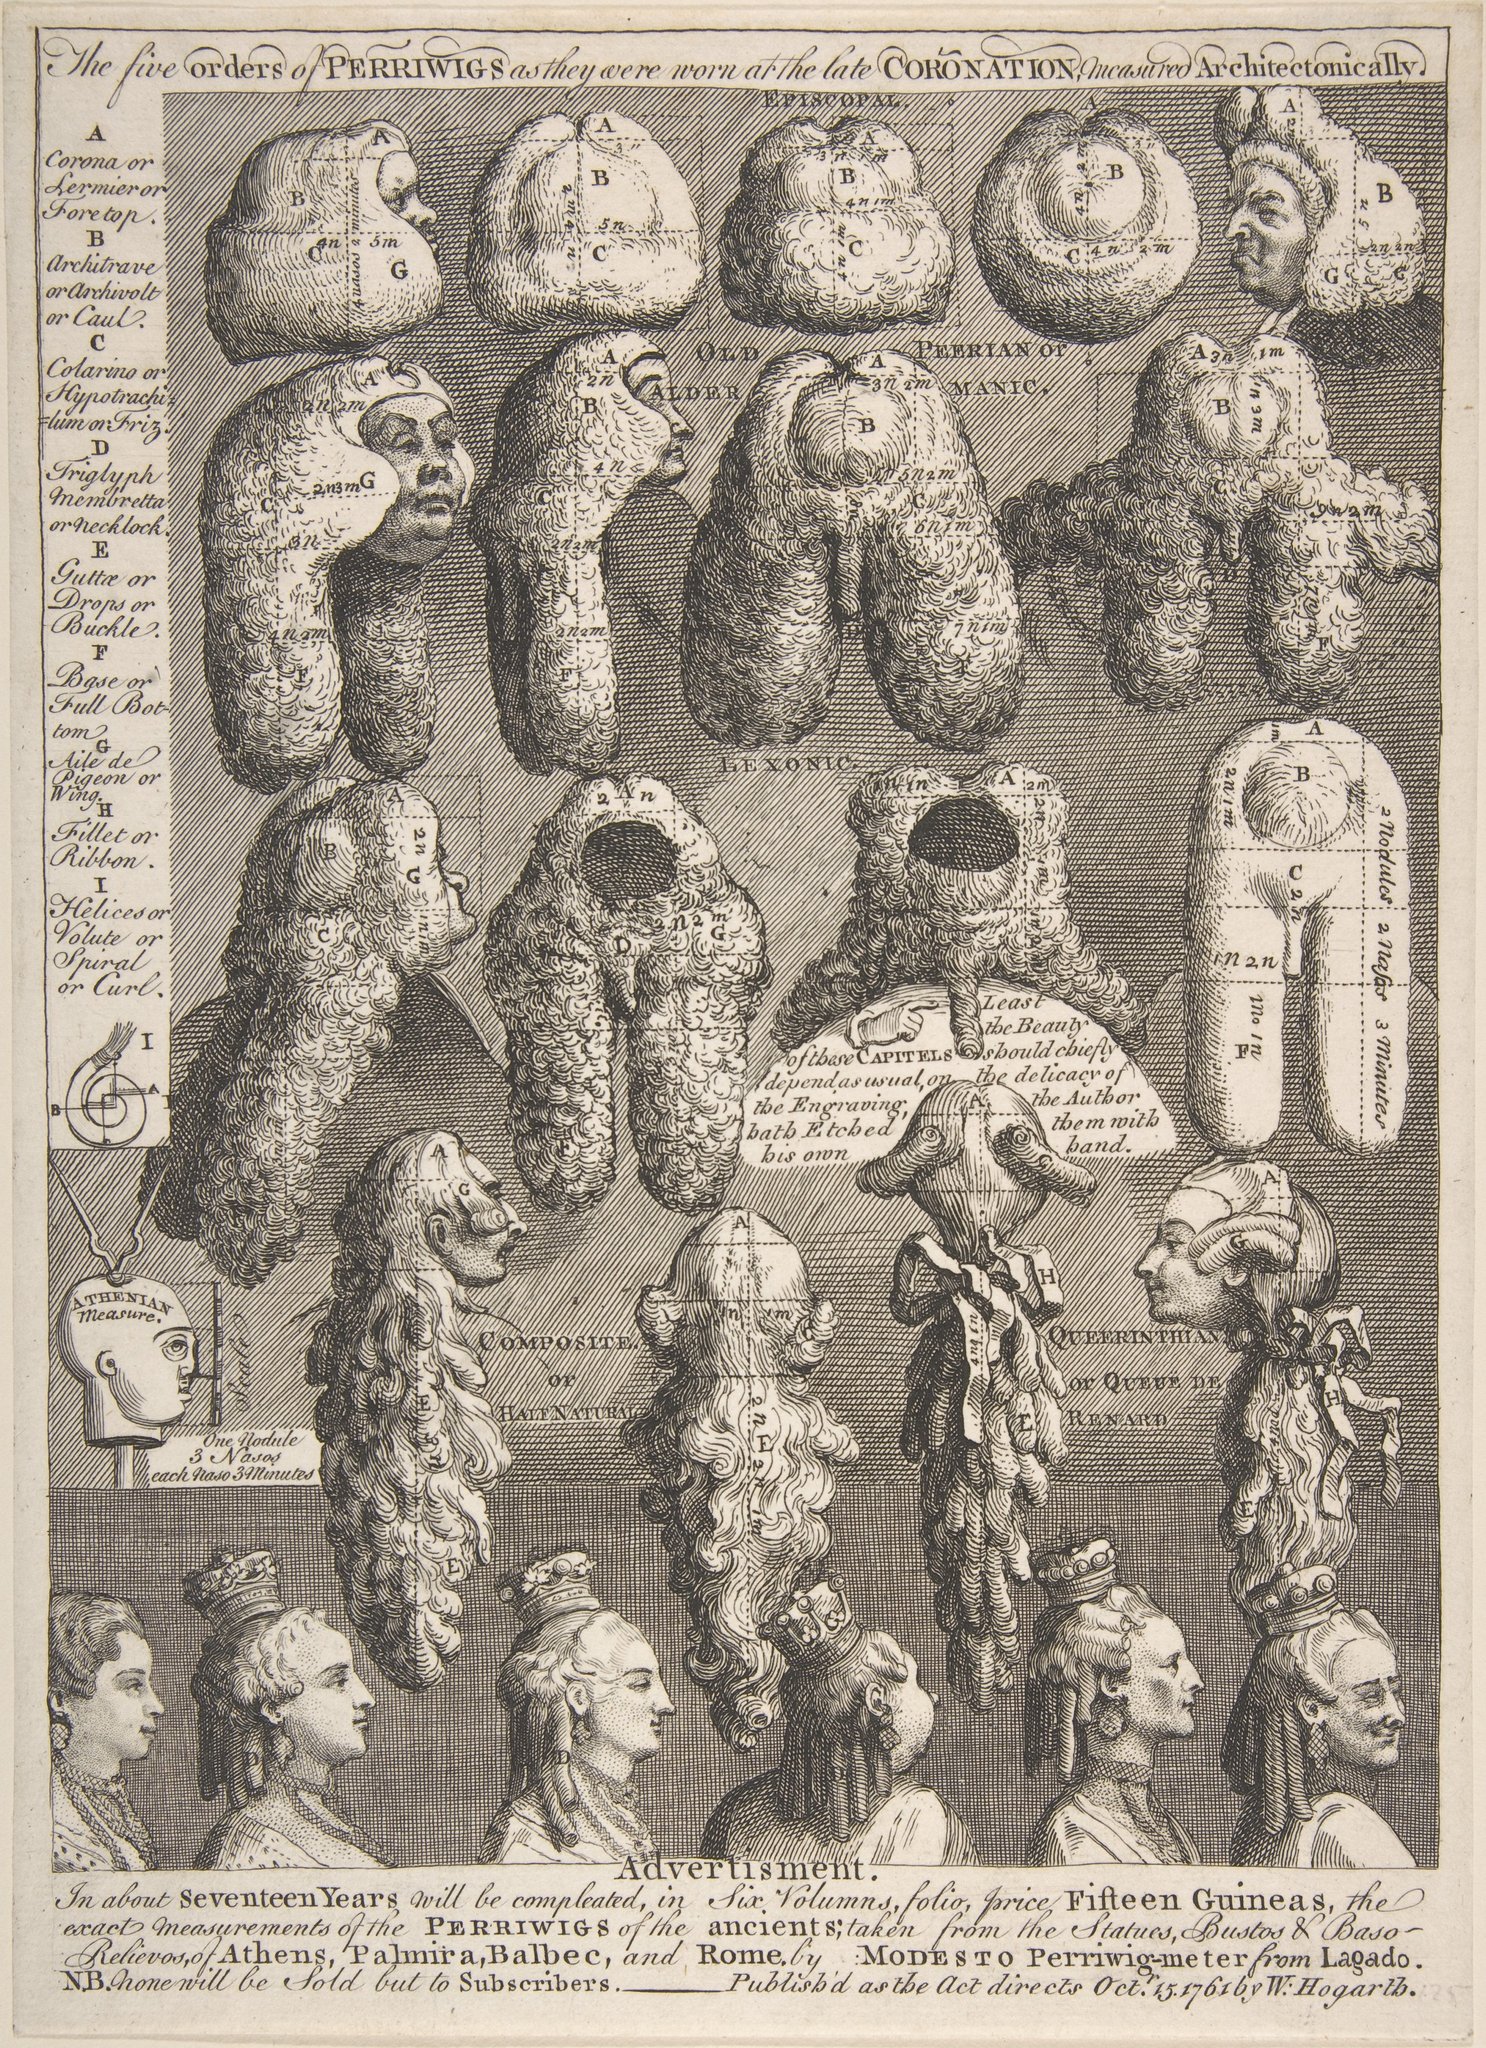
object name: print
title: The Five Orders of Periwigs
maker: william hogarth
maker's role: artist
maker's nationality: british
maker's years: 1697-1764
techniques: etching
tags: satire,hair,men,women,wigs